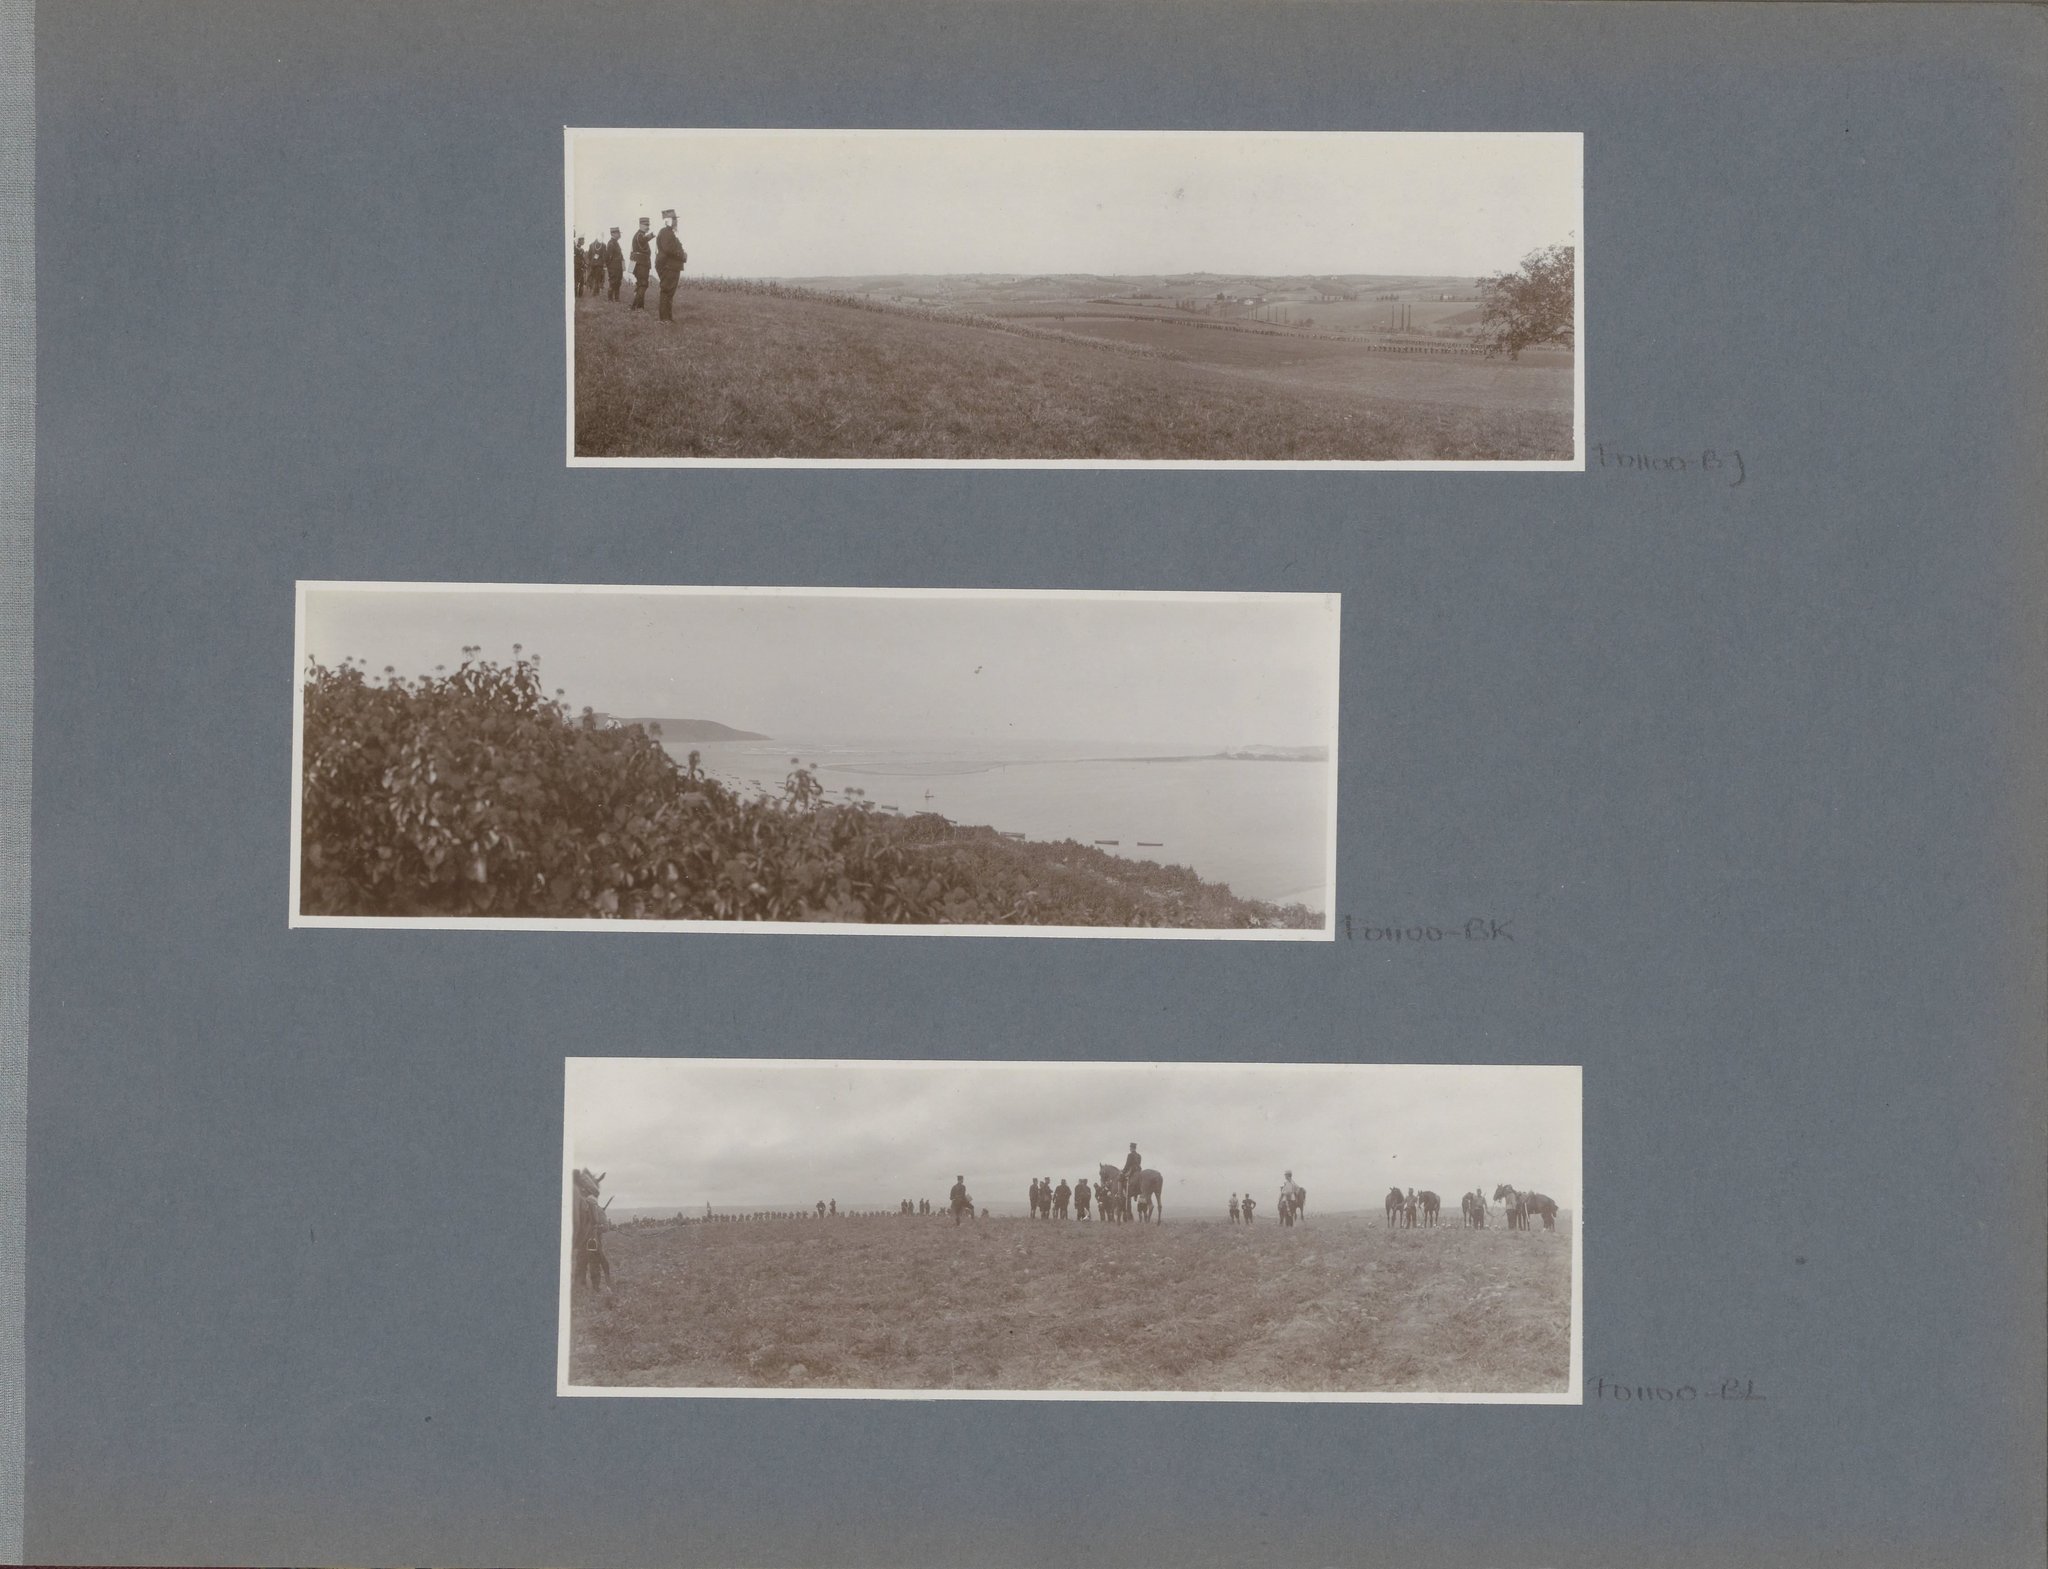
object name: album leaf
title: Cavalerie in een veld in Frankrijk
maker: Anonymous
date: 1902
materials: paper, photographic support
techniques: daylight paper print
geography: france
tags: land forces (+ cavalry, horsemen), manoeuvre ~ military training, france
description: Onderdeel van Fotoalbum van een legeroefening in Zuidwest-Frankrijk in 1902.